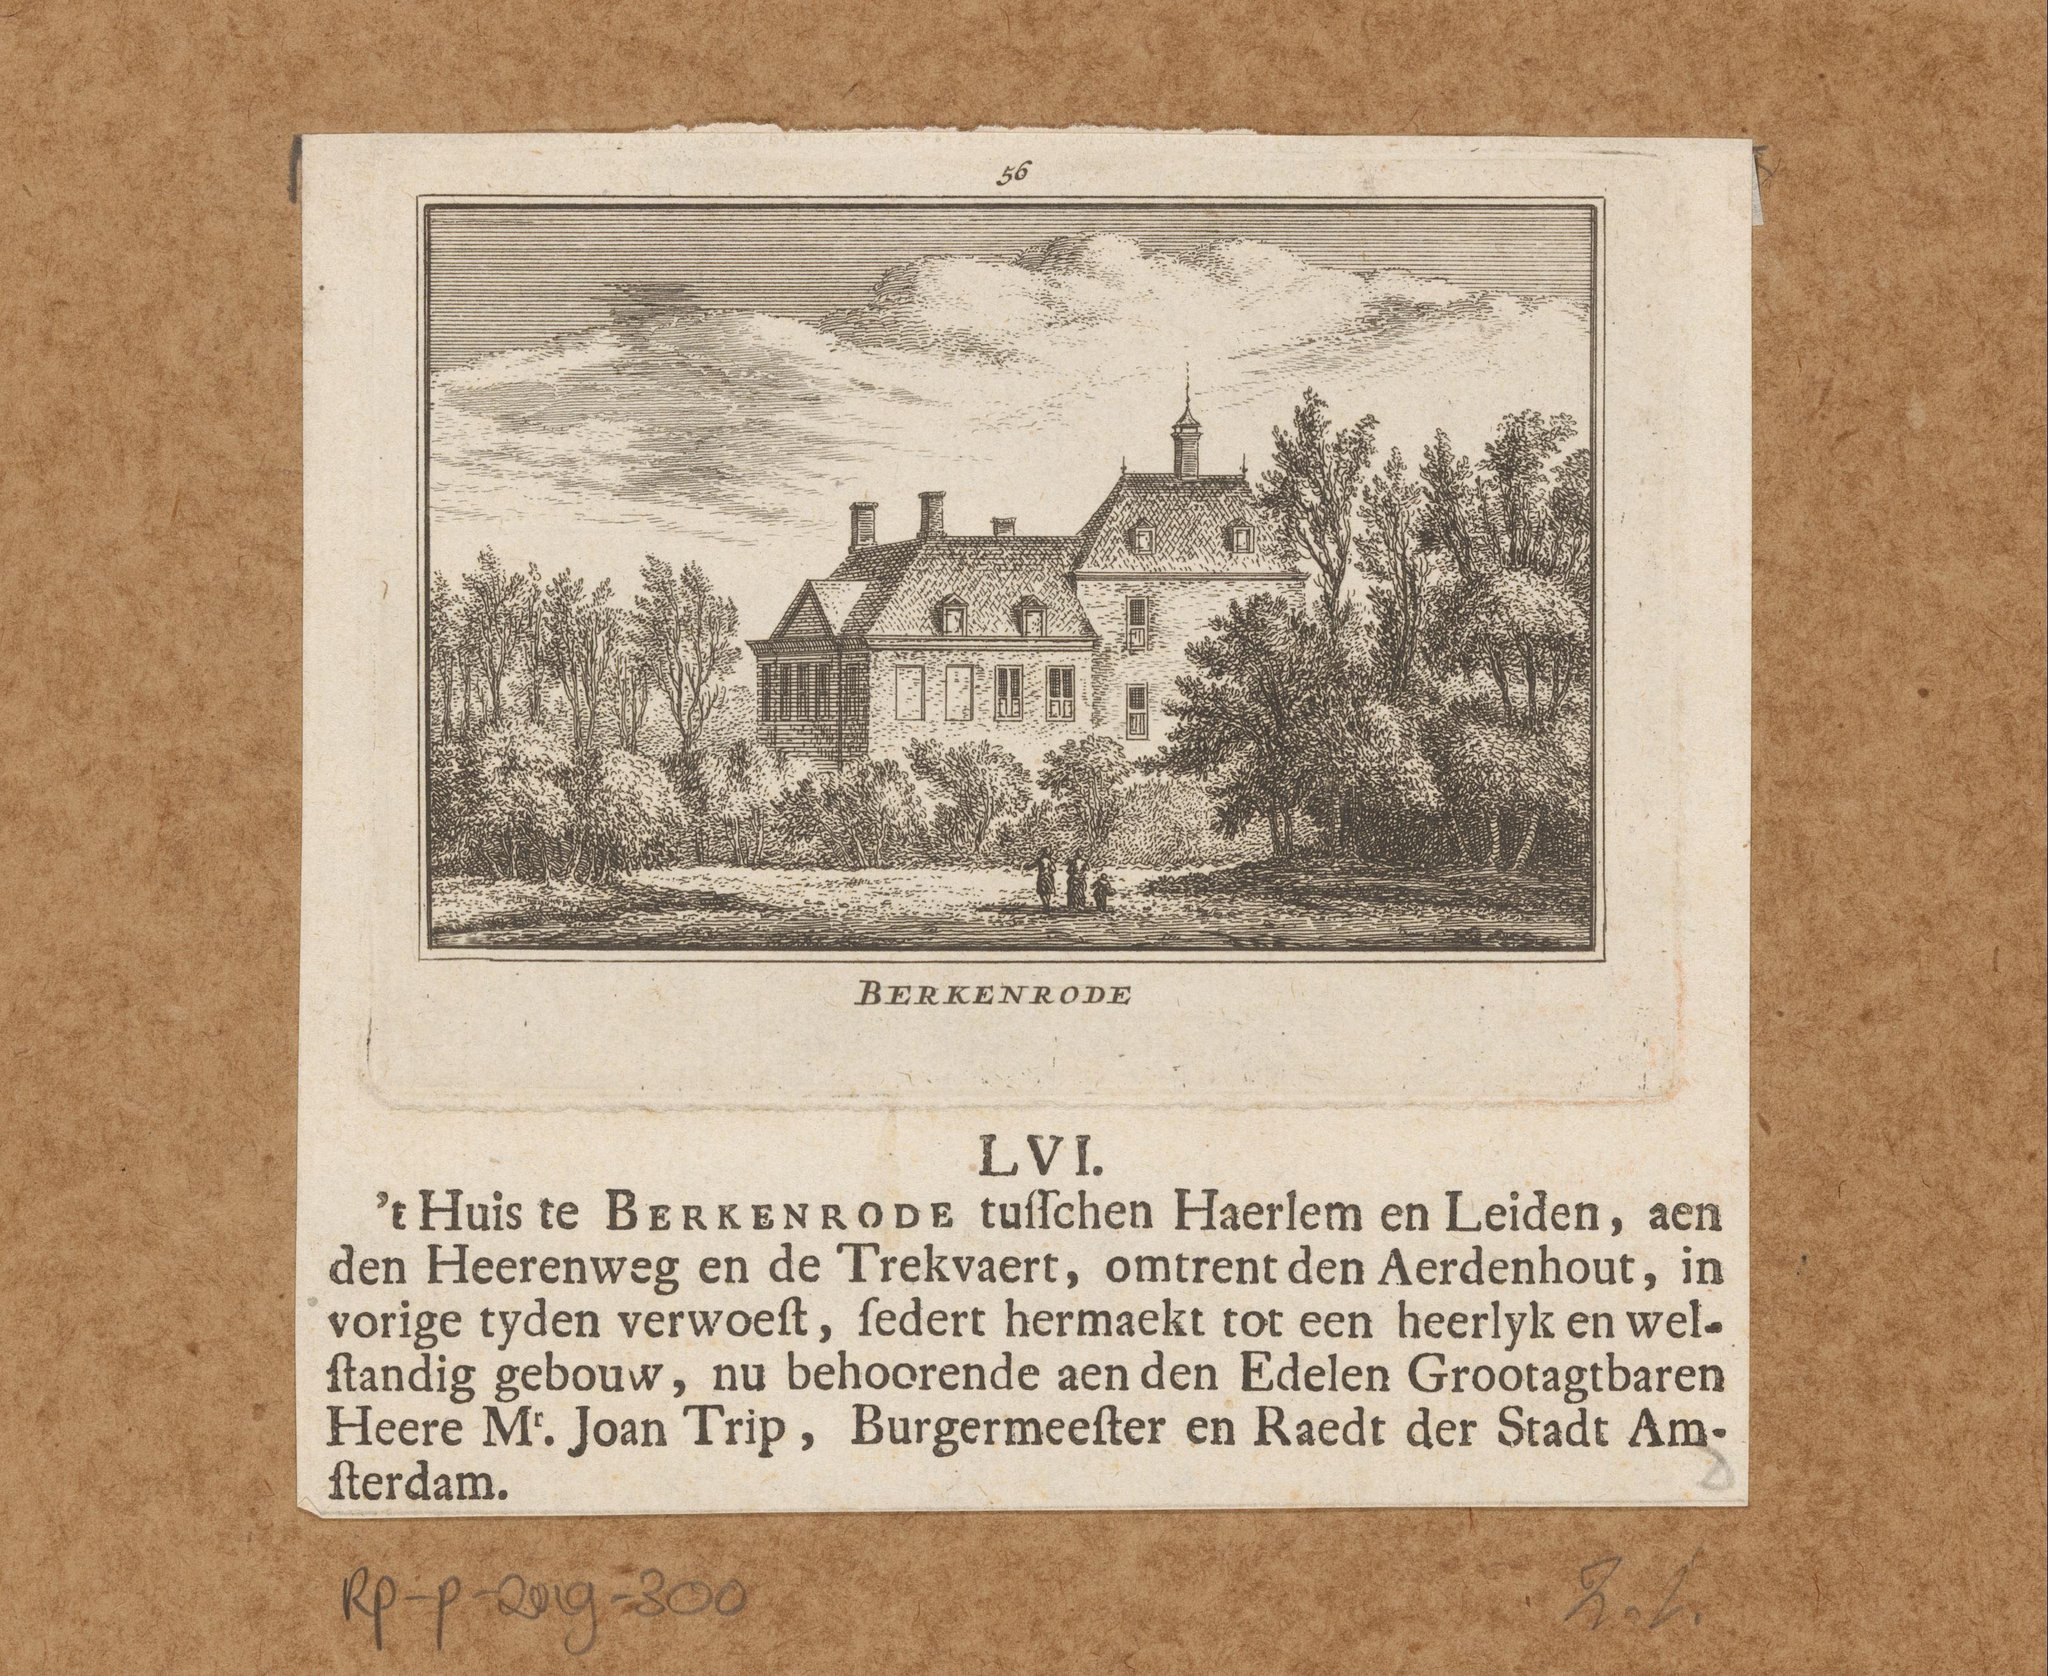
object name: print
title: Berkenrode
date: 1725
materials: paper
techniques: etching, letterpress printing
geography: amsterdam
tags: villa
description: Prent uit: Rademaker, Abraham, Matthaeus Brouërius van Niedek en Isaac Le Long. Kabinet van Nederlandsche en Kleefsche outheden en (...) voorname stads- en landgebouwen. Amsterdam: Willem Barents, 1725, ill. nr. 56. Of uit de heruitgave van 1727-1733.